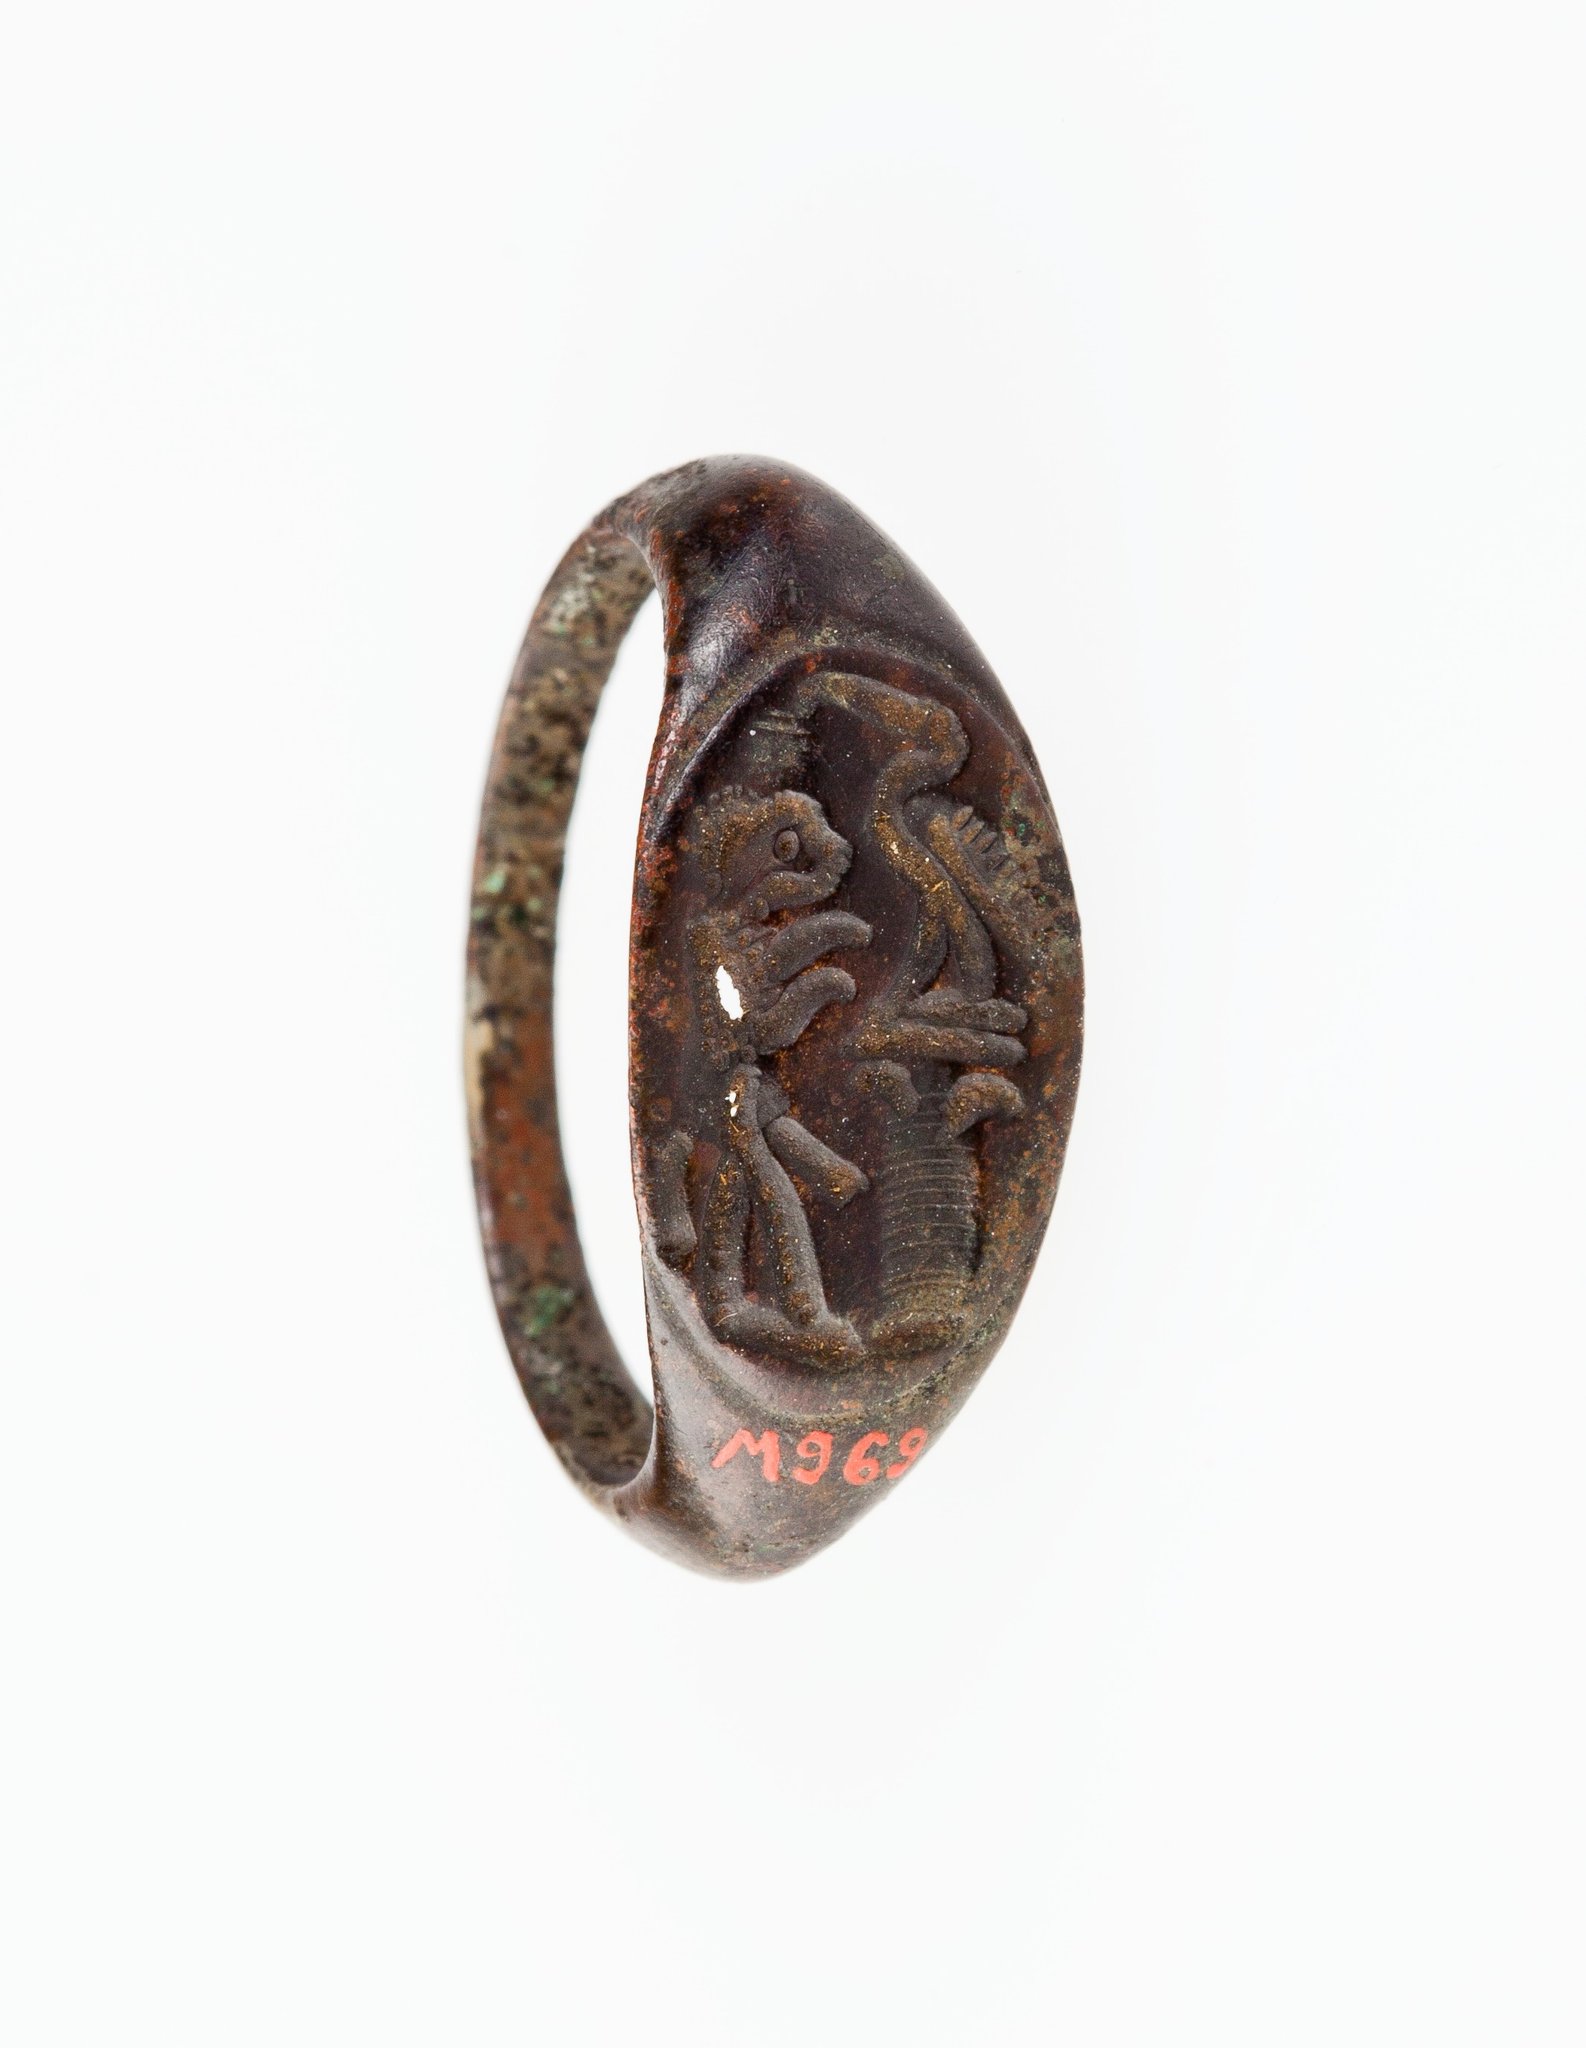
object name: ring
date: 304-30 BCE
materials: bronze, copper alloy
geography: egypt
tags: hieroglyphs